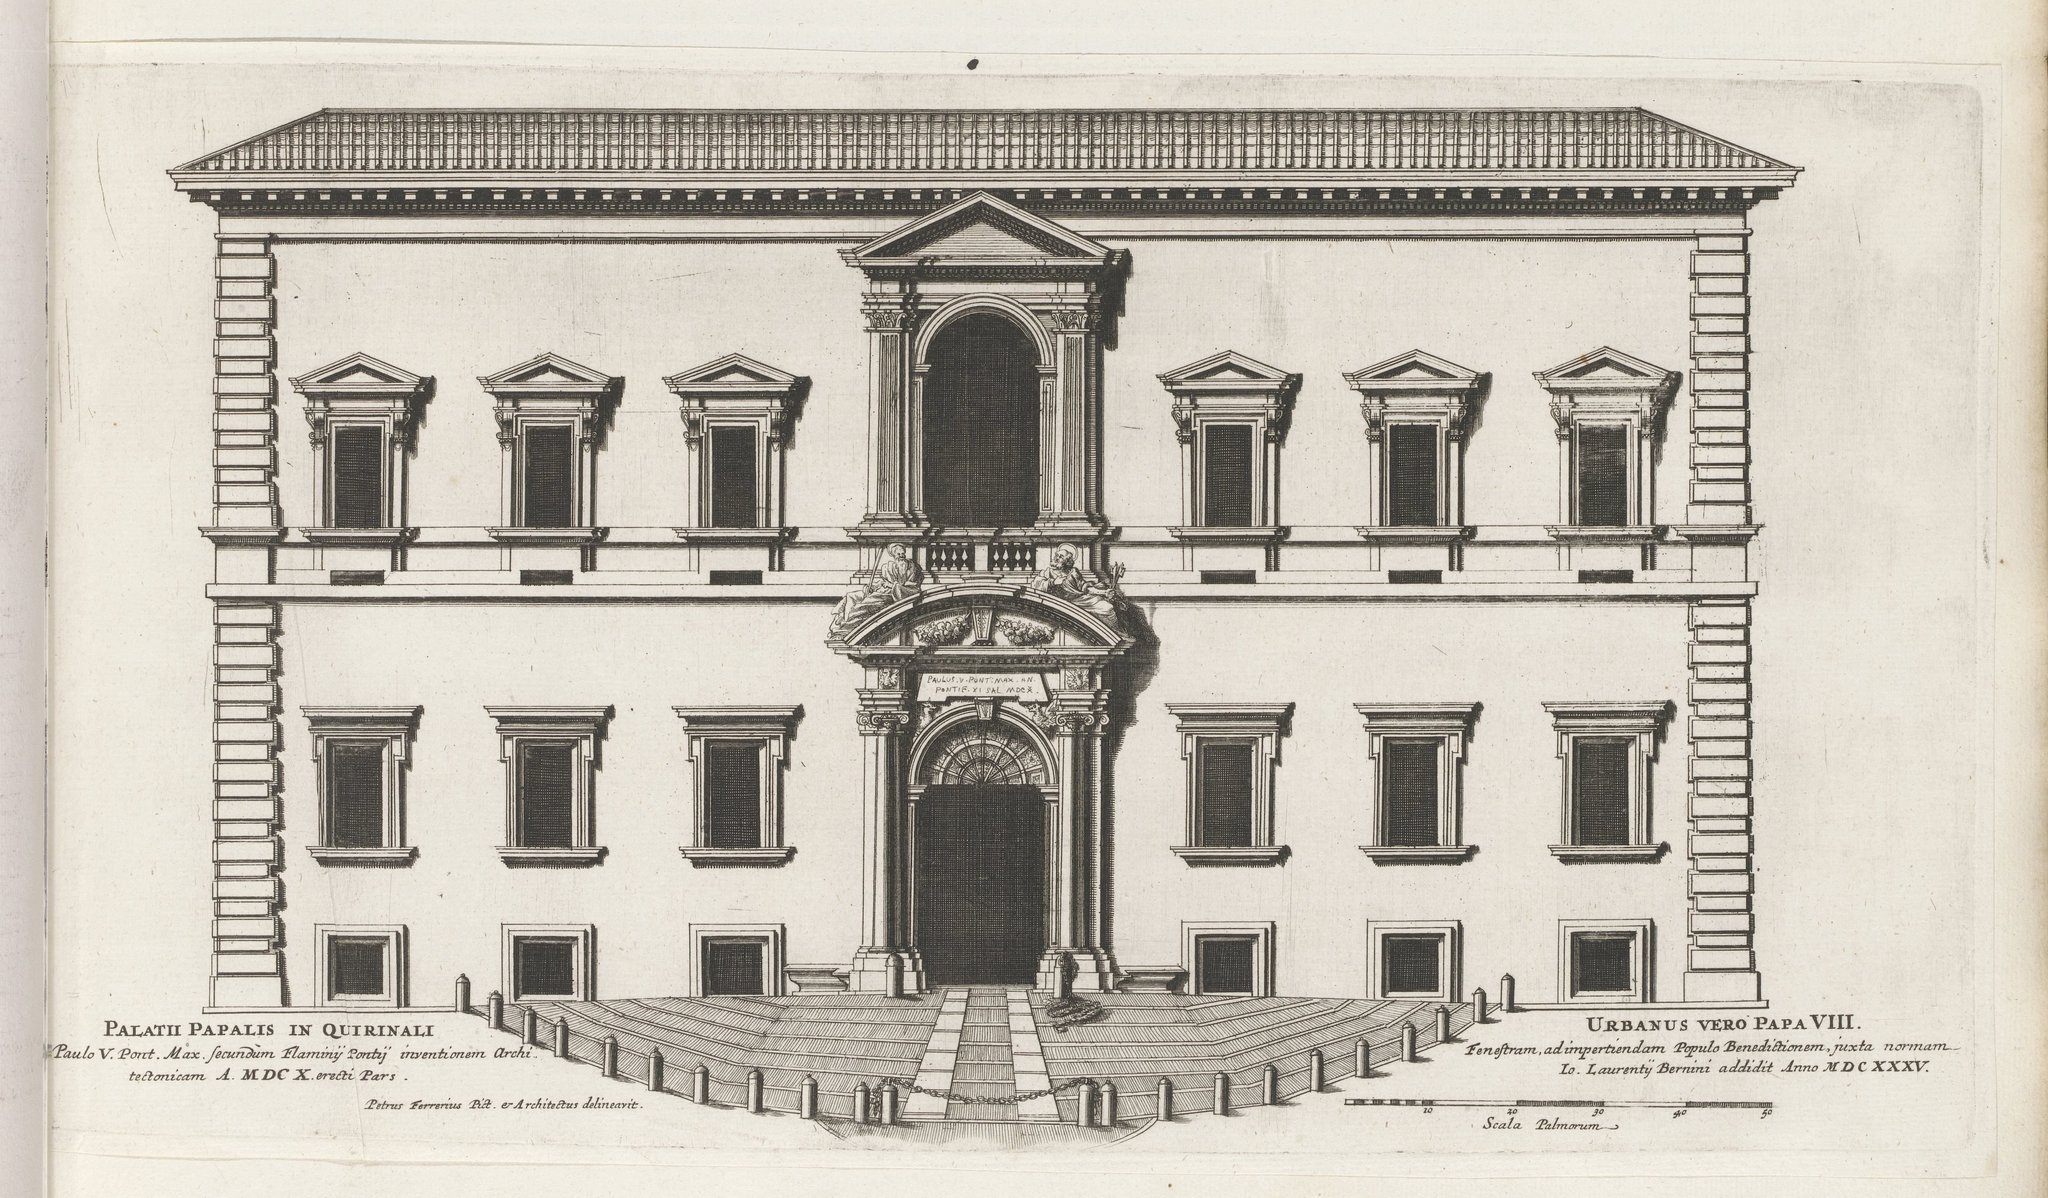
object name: print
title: Romeinse paleizen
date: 1655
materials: paper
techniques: etching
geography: italy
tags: urbanus viii, palace, façade (of house or building)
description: Deze prent maakt deel uit van de reeks getiteld: Palazzi di Roma. Deze reeks bestaat uit twee boeken. Boek één getiteld: Palazzi di Roma dei più celebri architetti..., bestaat uit 44 prenten die worden toegeschreven aan Giovanni Battista Falda (naam staat enkel op prent 27) en uitgegeven door Giovanni Giacomo de'Rossi. Deze 44 prenten zijn bekend in twee staten (met en zonder nummer). Boek twee getiteld: Nuovi disegni dell'architetture... libro secondo, bevat 66 prenten door Giovanni Battista Falda en Simone Felice. Deze 66 prenten zijn bekend in twee staten (met en zonder nummer).